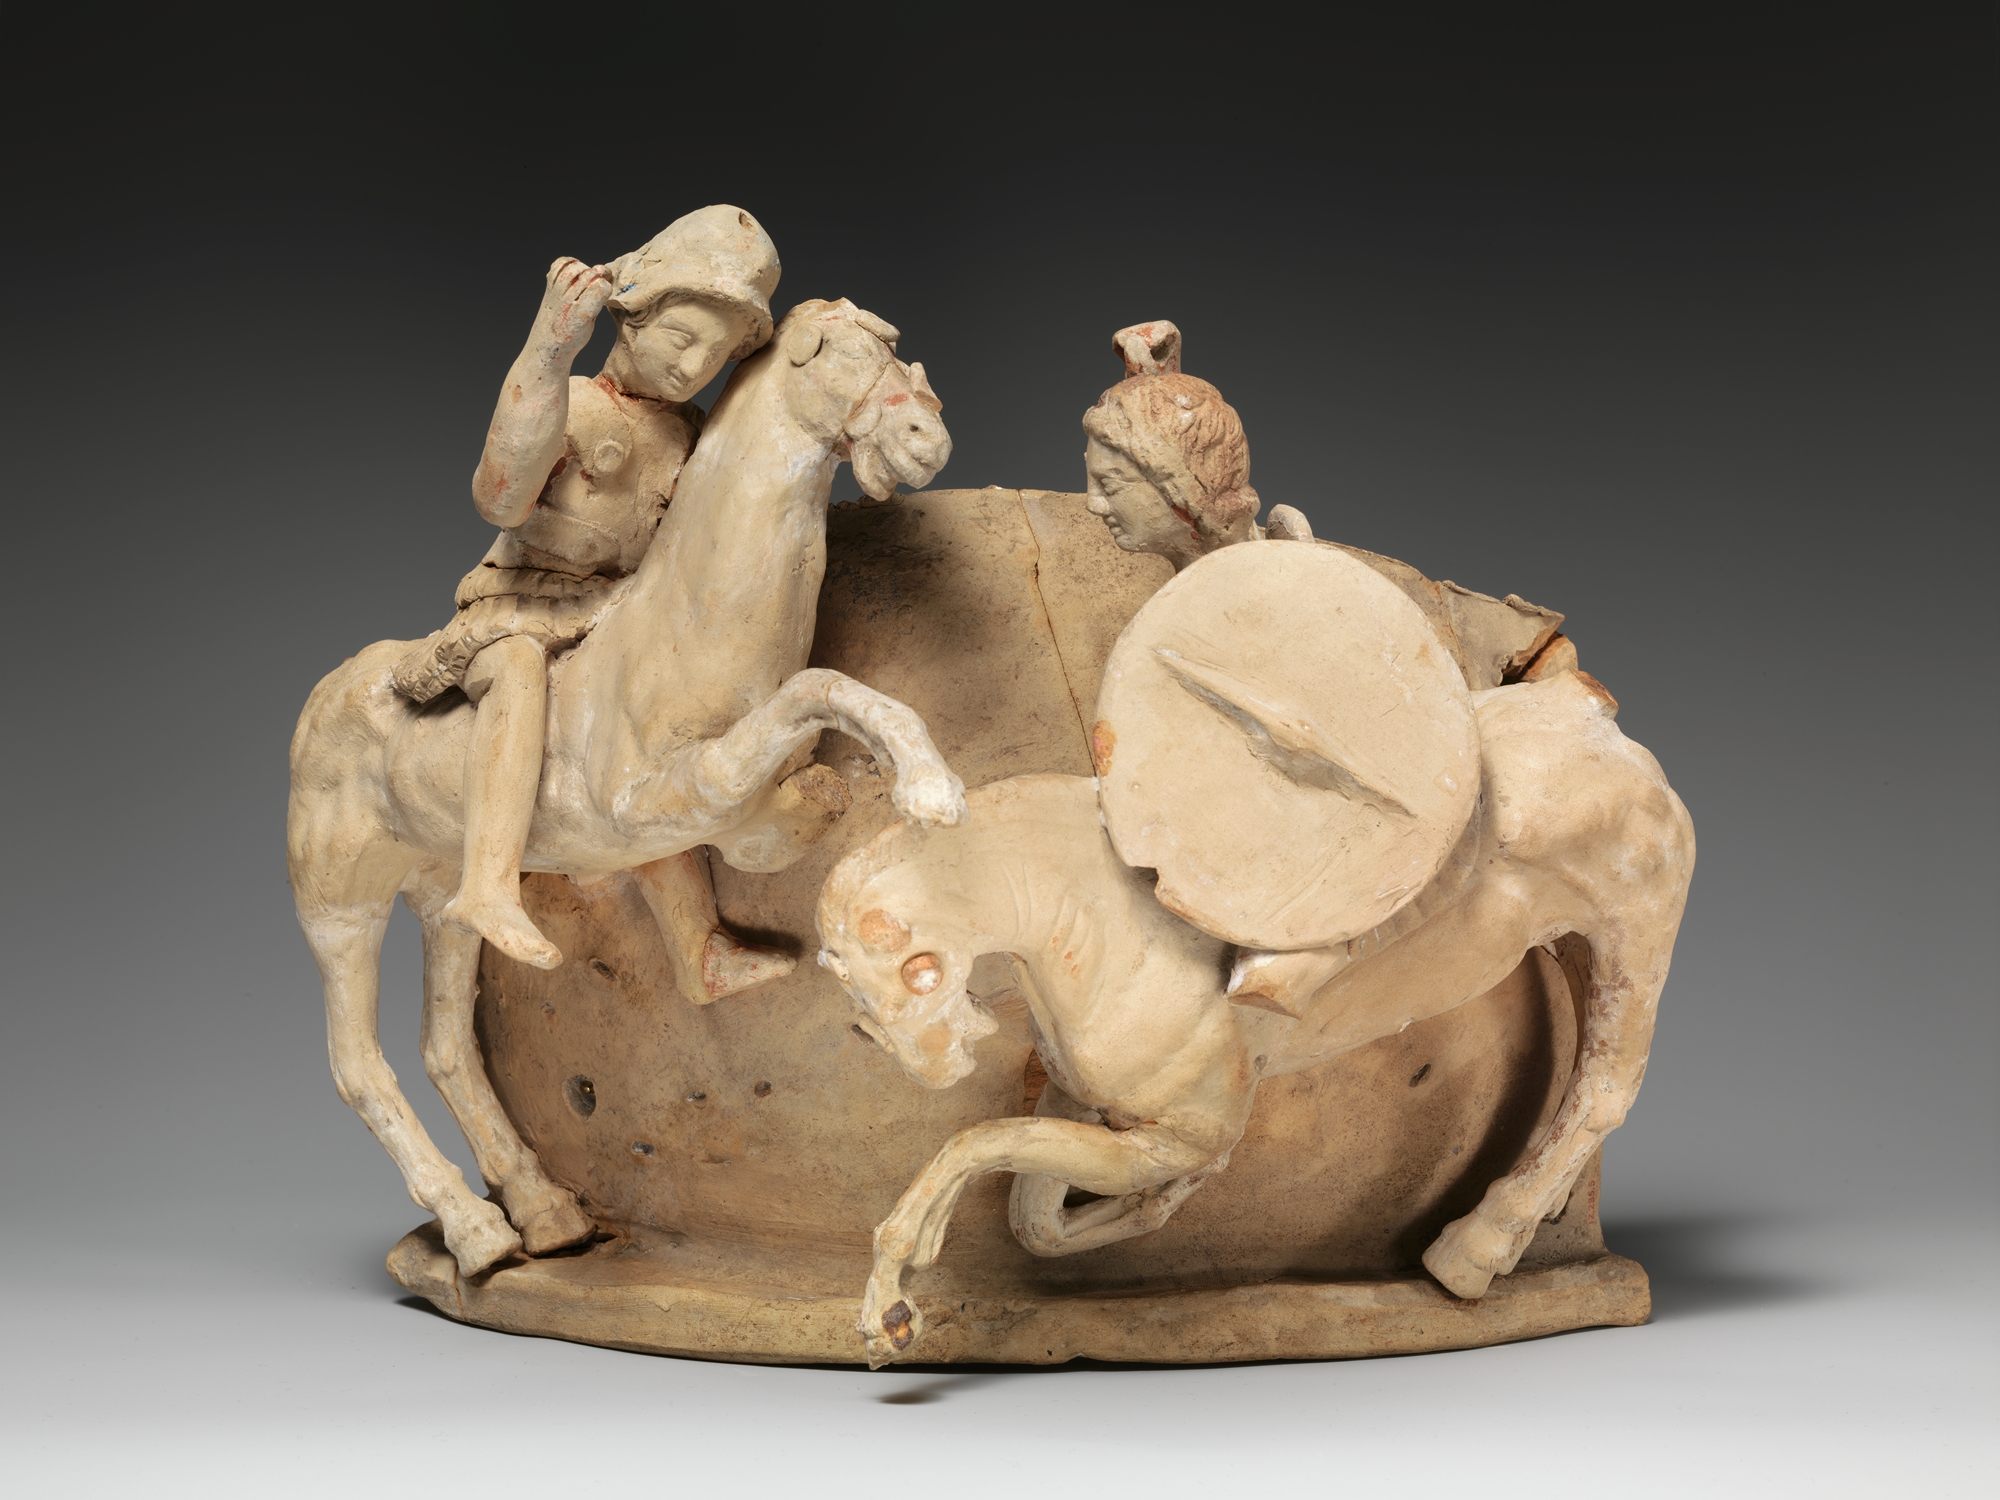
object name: vase, relief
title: Terracotta relief probably from a funnel vase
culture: greek, south italian, apulian, canosan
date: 234-168 BCE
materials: terracotta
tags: shields,men,horses